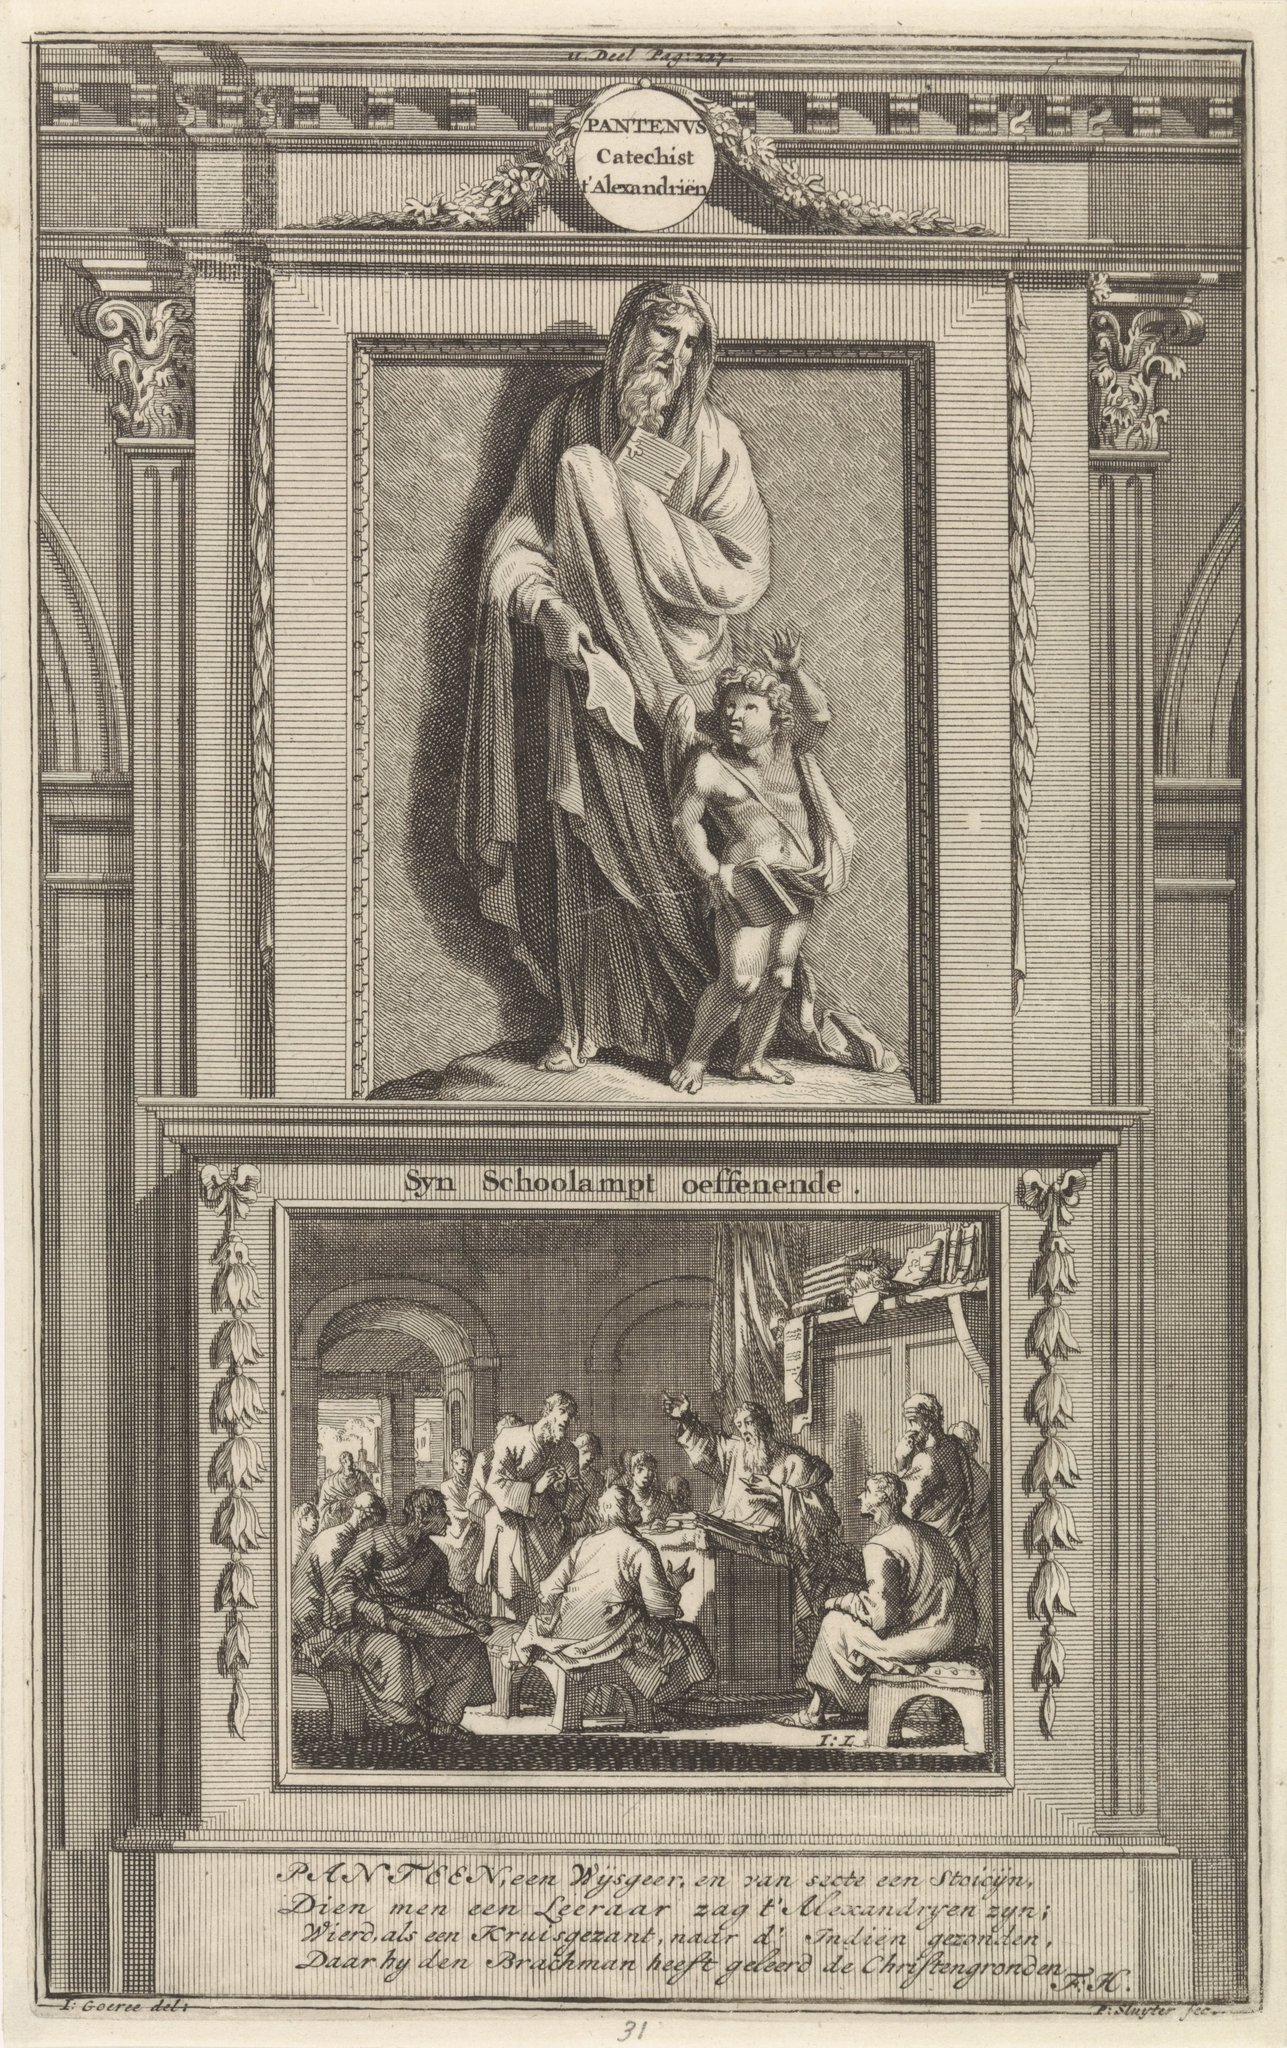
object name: book illustration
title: Pantenus Catechist t'Alexandriën, Syn Schoolampt oeffenende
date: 1698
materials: paper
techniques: engraving, etching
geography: amsterdam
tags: male saints (pantaenus of alexandria) - male saint writing, studying, teaching, dictating (e.g. as doctor of the church), male saints (pantaenus of alexandria)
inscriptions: number: ‘31’, collector's mark: Lugt 2228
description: De heilige kerkvader Pantenus van Alexandrië met een boek in zijn handen. Voor hem staat een engel eveneens met een boek. Pantenus staat op een sokkel waar op de voorzijde zijn onderricht in de School van Alexandrië in beeld is gebracht. Prent middenboven gemerkt: II Deel Pag: 227.